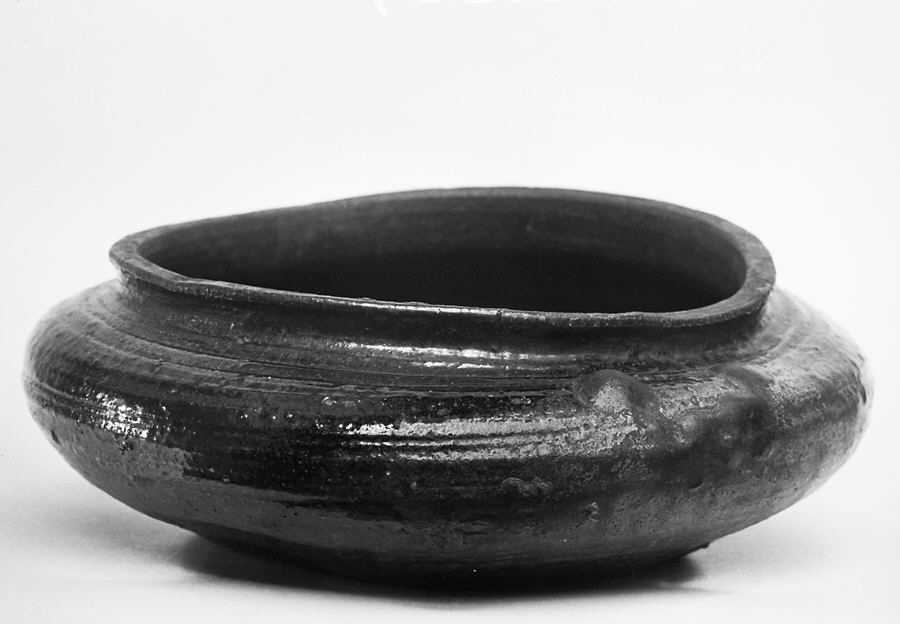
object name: waste water basin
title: Waste-water basin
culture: japanese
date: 1775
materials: pottery